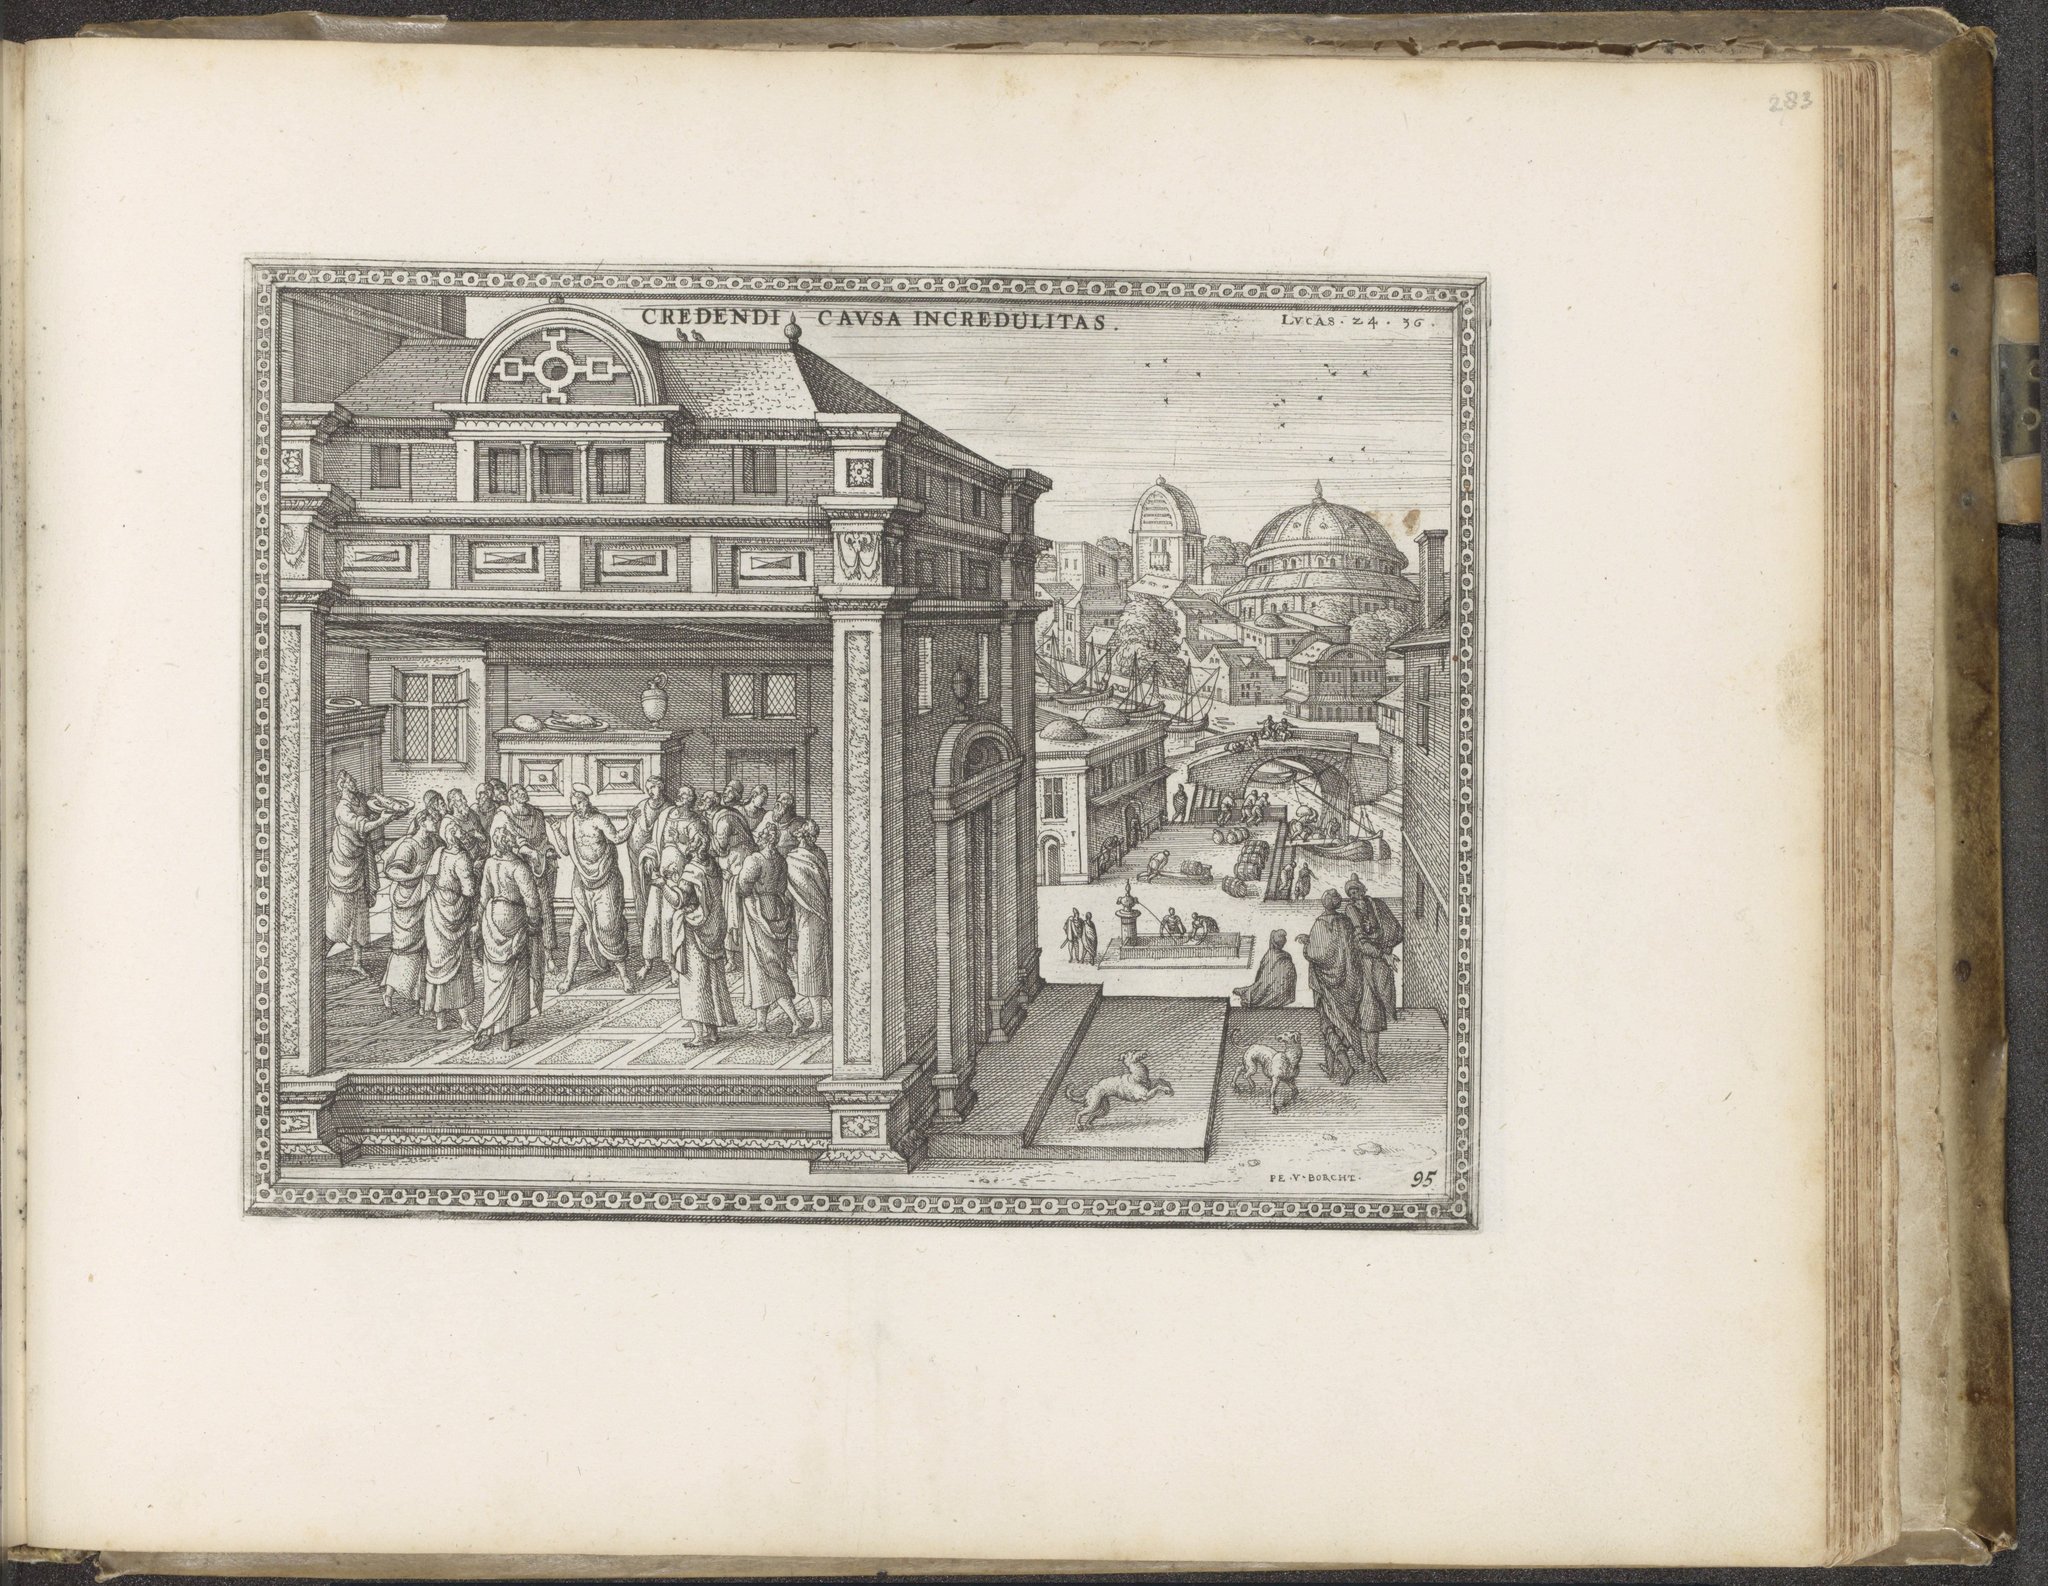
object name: album leaf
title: Den Grooten Emblemata Sacra, bestaande in meer dan vier hondert bybelsche figuren, zoo des Ouden als des Nieuwen Testaments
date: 1582-1593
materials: paper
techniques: etching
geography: amsterdam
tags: christ showing his wounds to the apostles, christ appears to the apostles (gathered behind locked doors)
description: In een gebouw met gesloten deuren verschijnt Christus na zijn opstanding aan de apostelen. Hij toont hen zijn wonden (Luc. 24). Rechts de stad Jeruzalem. De prent maakt deel uit van een album.